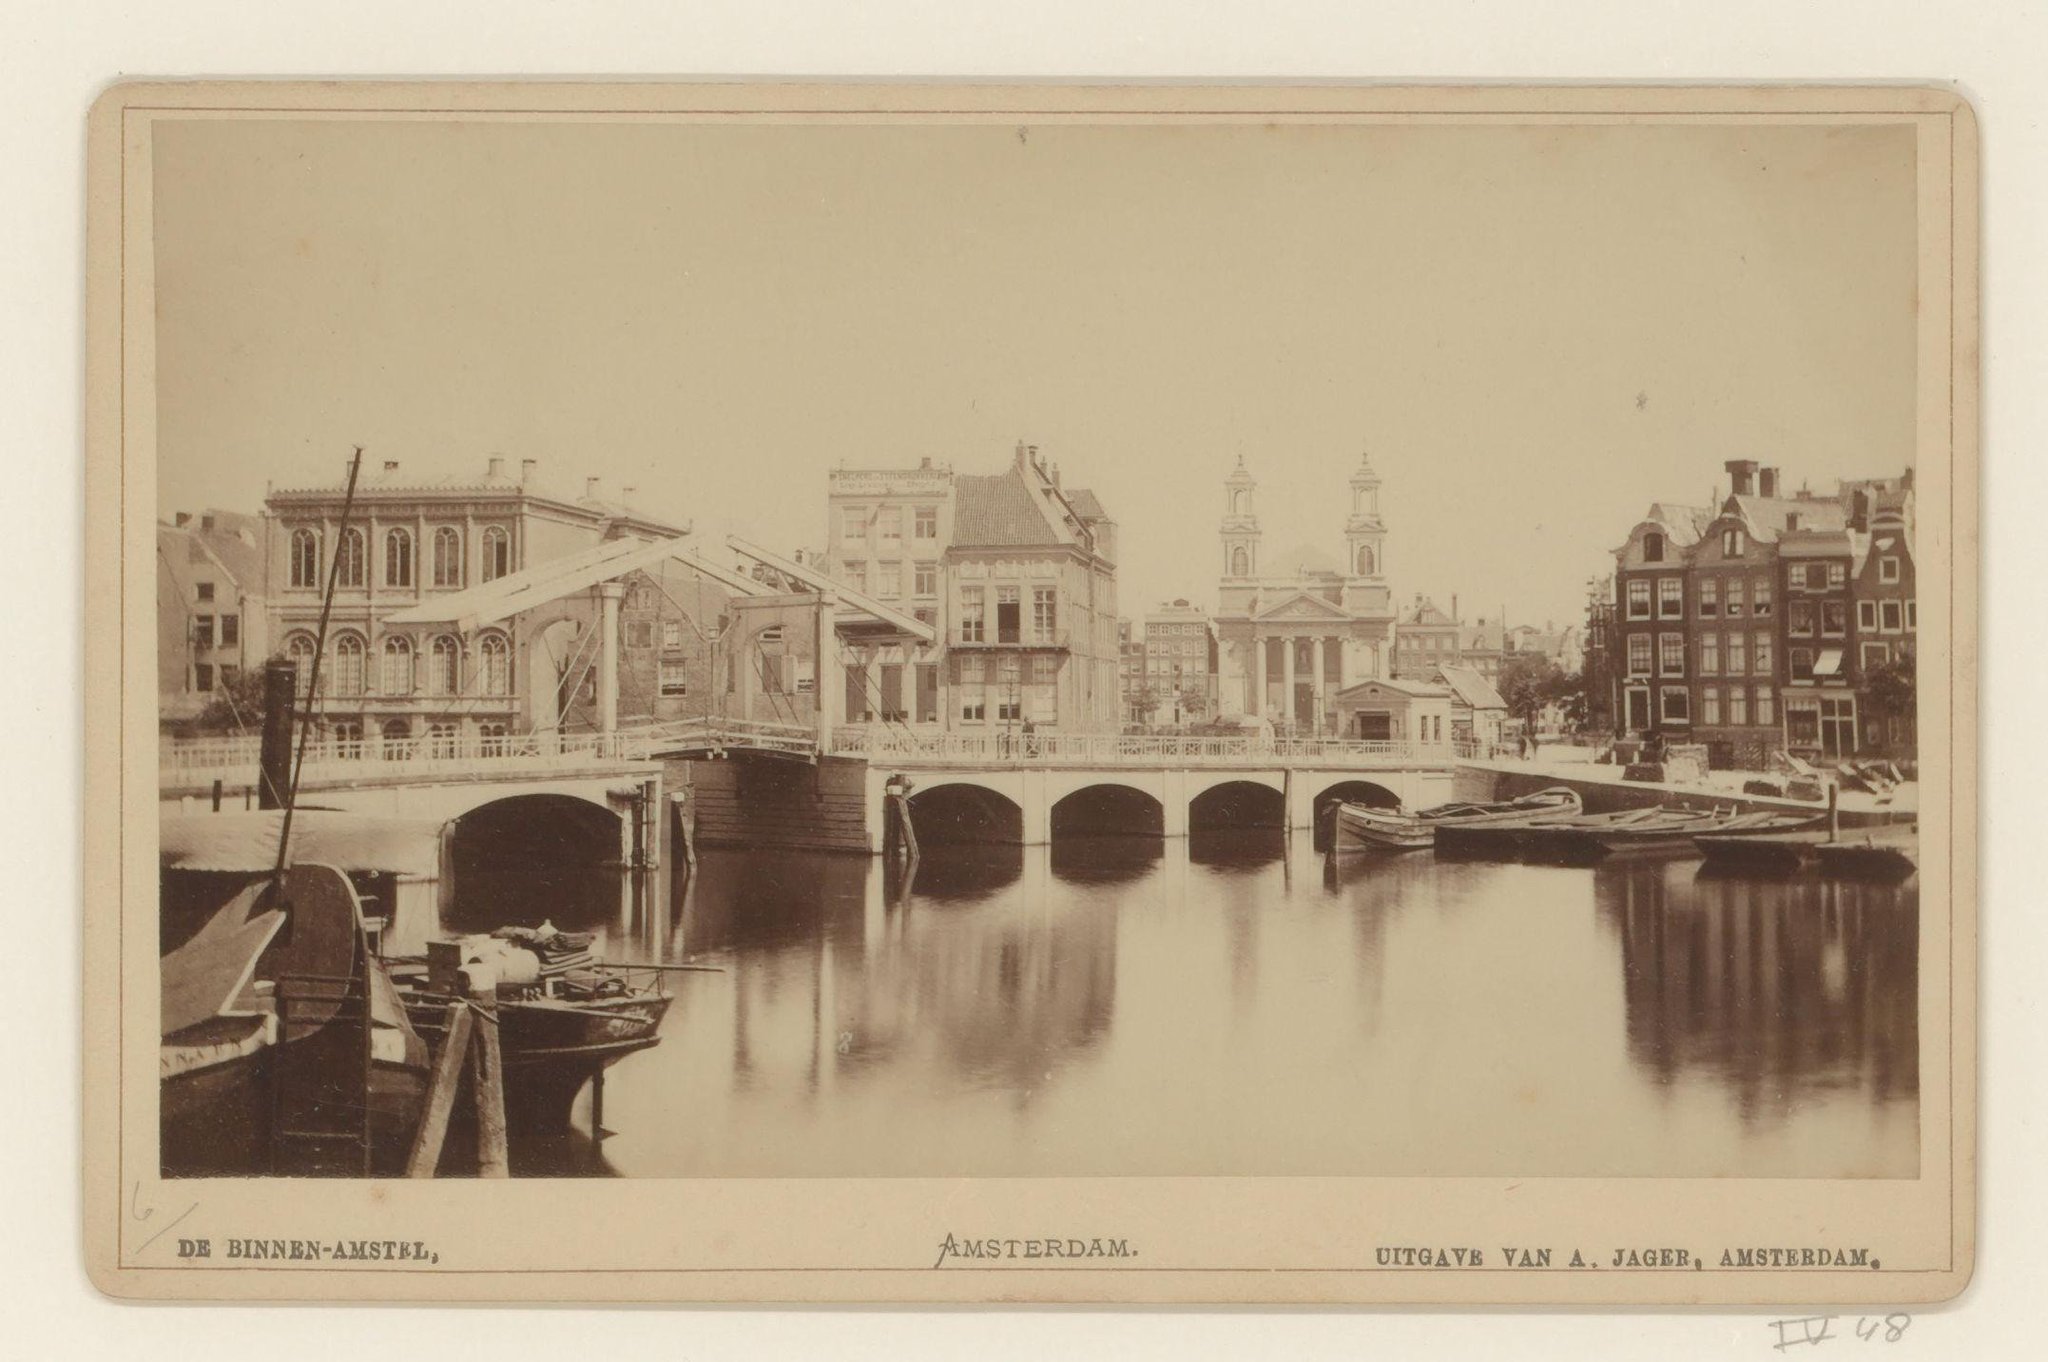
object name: cabinet photograph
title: Gezicht op de Blauwbrug en de Mozes en Aäronkerk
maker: andries jager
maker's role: publisher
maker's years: 1825-1905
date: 1875-1882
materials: cardboard, paper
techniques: albumen print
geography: amsterdam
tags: city-view in general; 'veduta', canal, church (exterior), bridge in city across river, canal, etc.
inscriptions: collector's mark: ‘4’ Lugt 1641b, inscription: ‘Oude Blauwbrug. / 86.’, stamp: ‘Gebr. Douwes / Atelier / Grimburgwal 15 / Amsterdam’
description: Onderwerpsrubriek binnen de Atlas Amsterdam: Amstel van Blauwbrug tot Hogesluis.